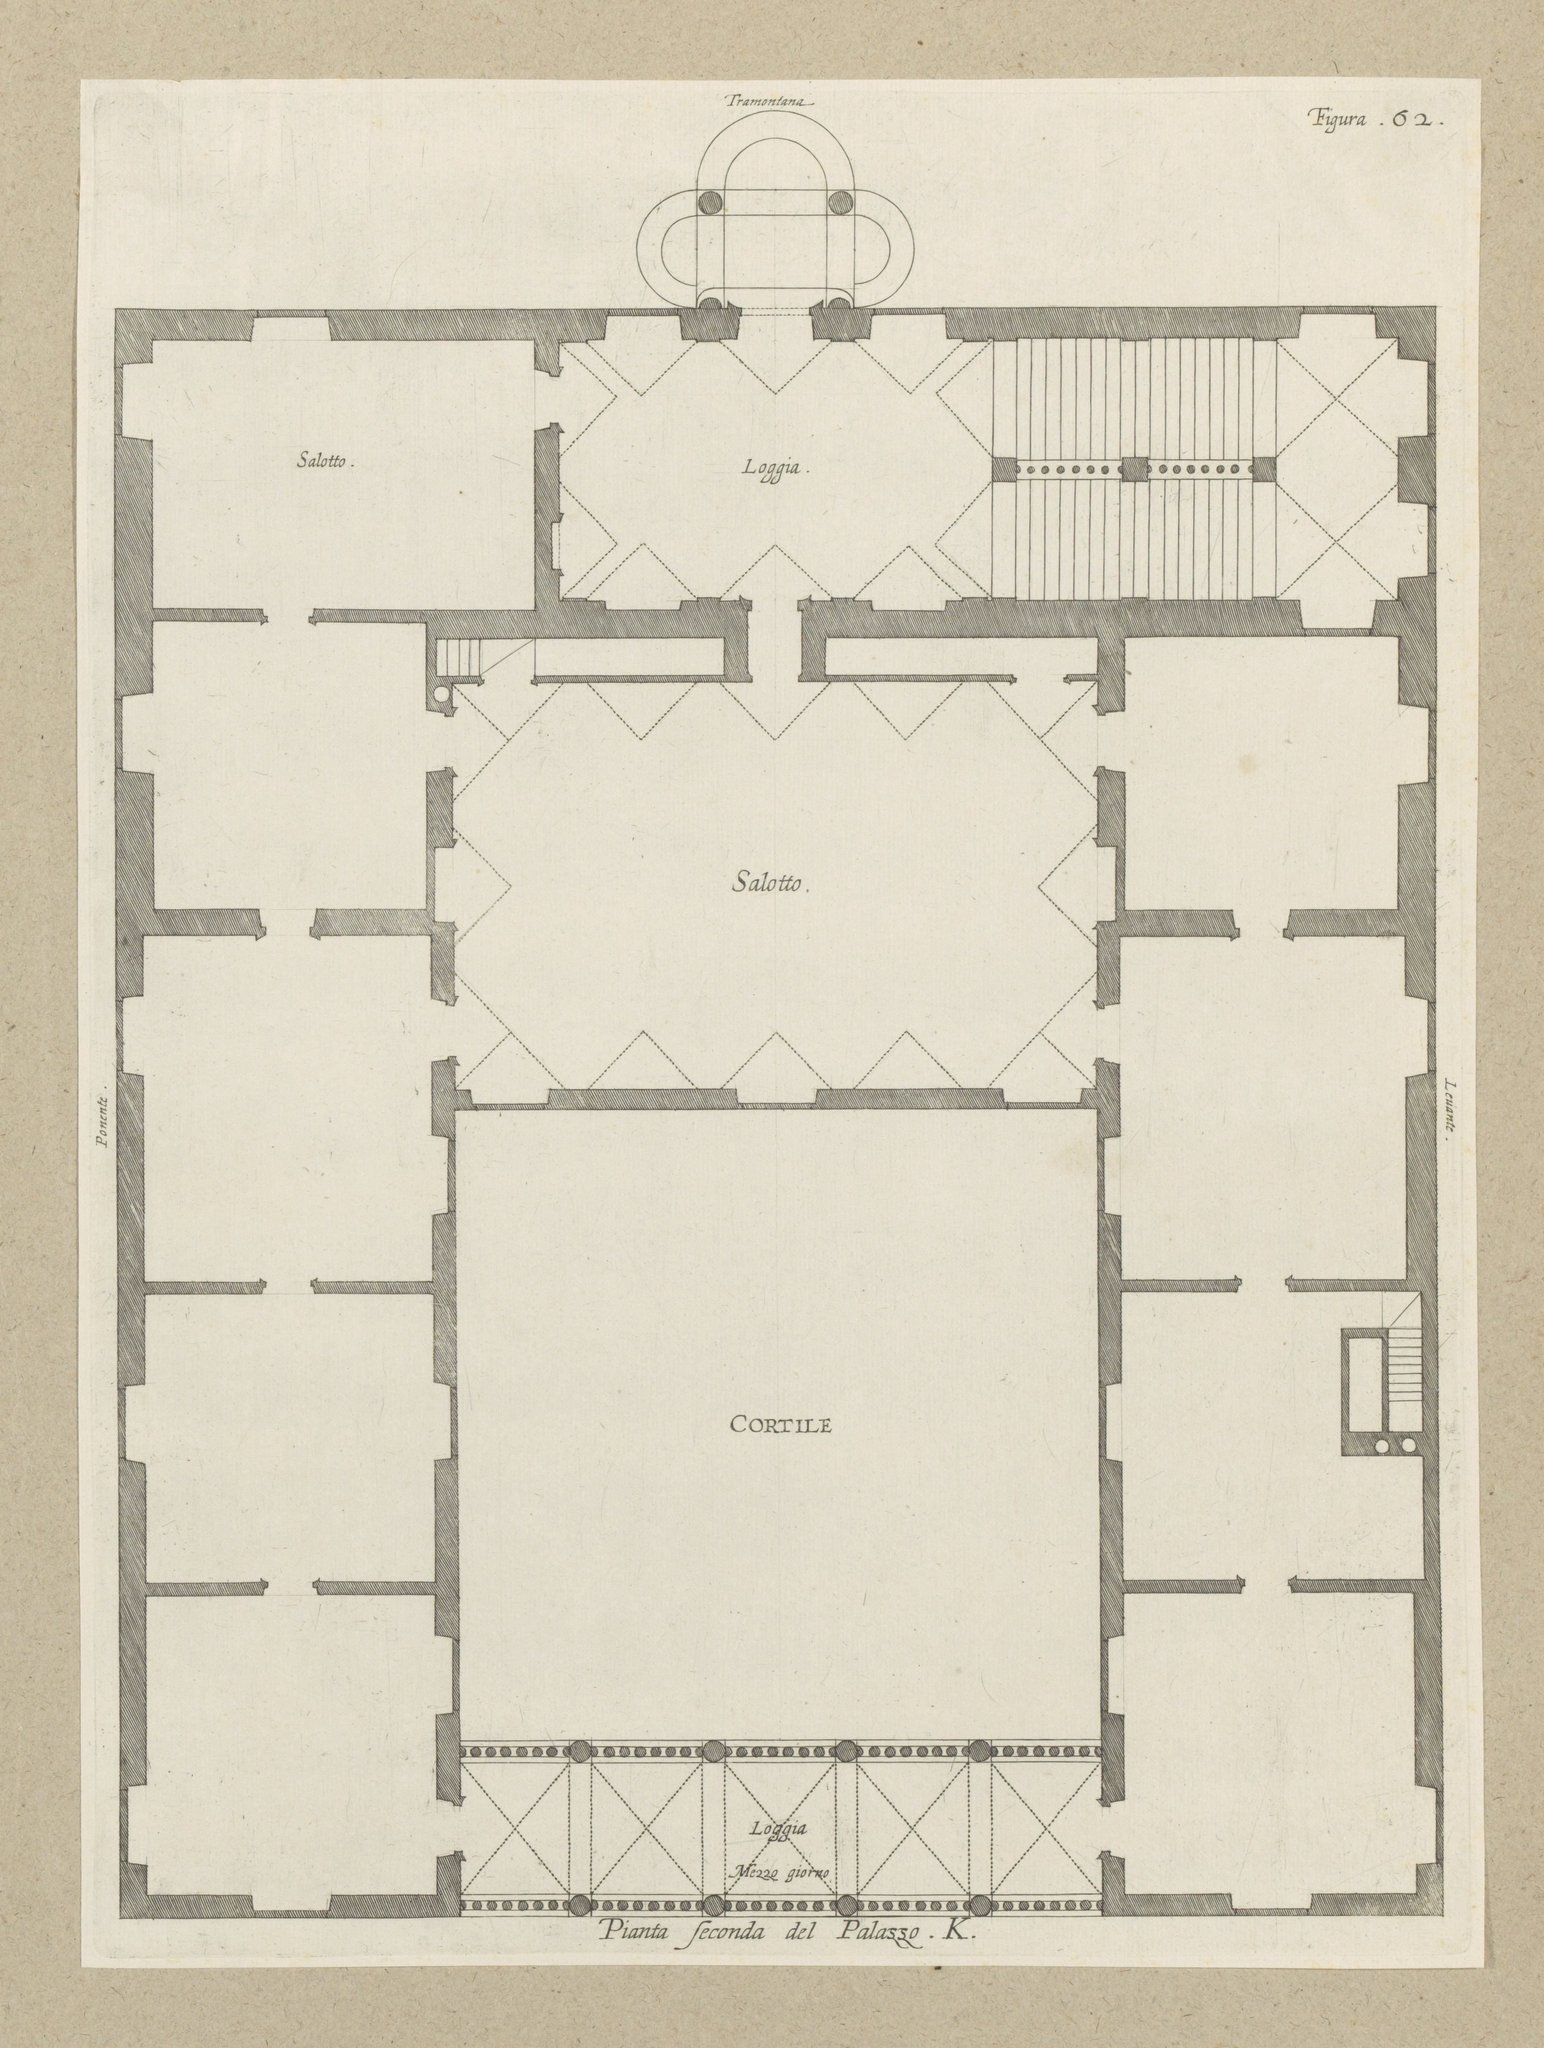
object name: print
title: Plattegrond van de eerste verdieping van het Palazzo Lercari-Parodi te Genua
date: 1622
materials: paper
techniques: engraving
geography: antwerp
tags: hôtel, i.e. small palace in city - aa - civic architecture: inside, plan ~ architecture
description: Deze prent maakt deel uit van een album.